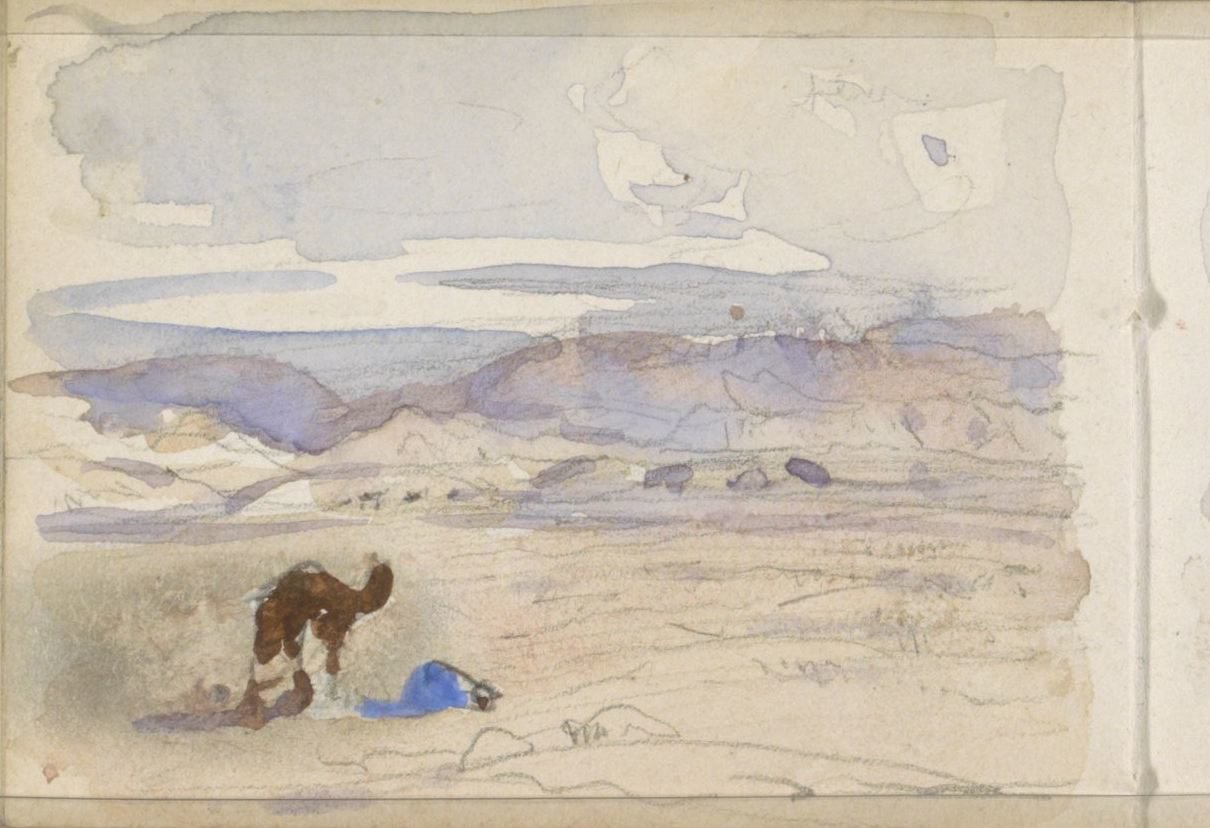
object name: sketchbook leaf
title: Kameel in een woestijnlandschap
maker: marius bauer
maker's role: draughtsman, print maker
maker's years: 1867-1932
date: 1922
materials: paper, pencil, watercolor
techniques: brush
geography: biskra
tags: hoofed animals: camel, desert, mountains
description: Op de achtergrond vermoedelijk het Atlasgebergte. Pagina 38 uit een schetsboek met 32 bladen.